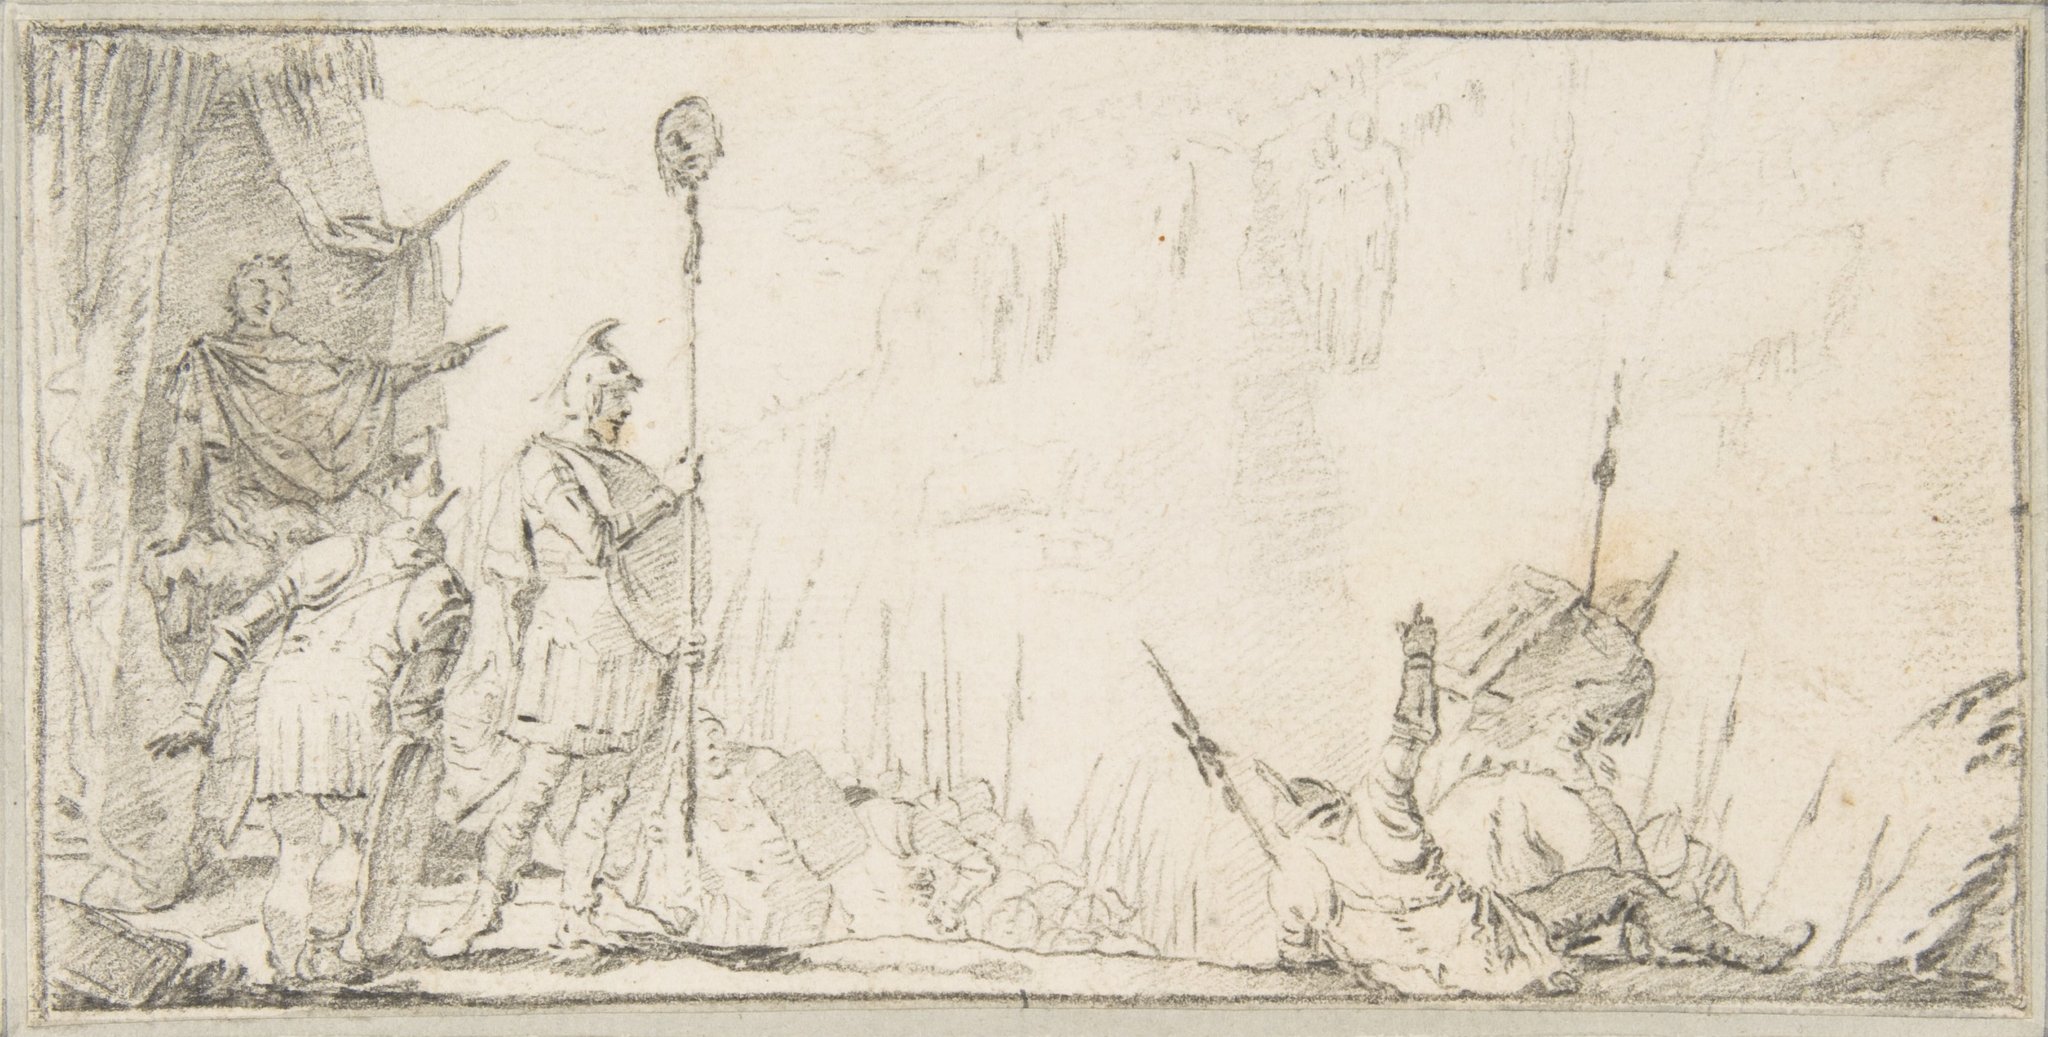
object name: drawing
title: Illustration for a Book: Soldier in front of "General" Holding up a Decapitated Head on a Staff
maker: giovanni battista tiepolo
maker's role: artist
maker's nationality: italian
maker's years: 1696-1770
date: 1696-1770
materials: chalk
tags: soldiers,heads,men,generals